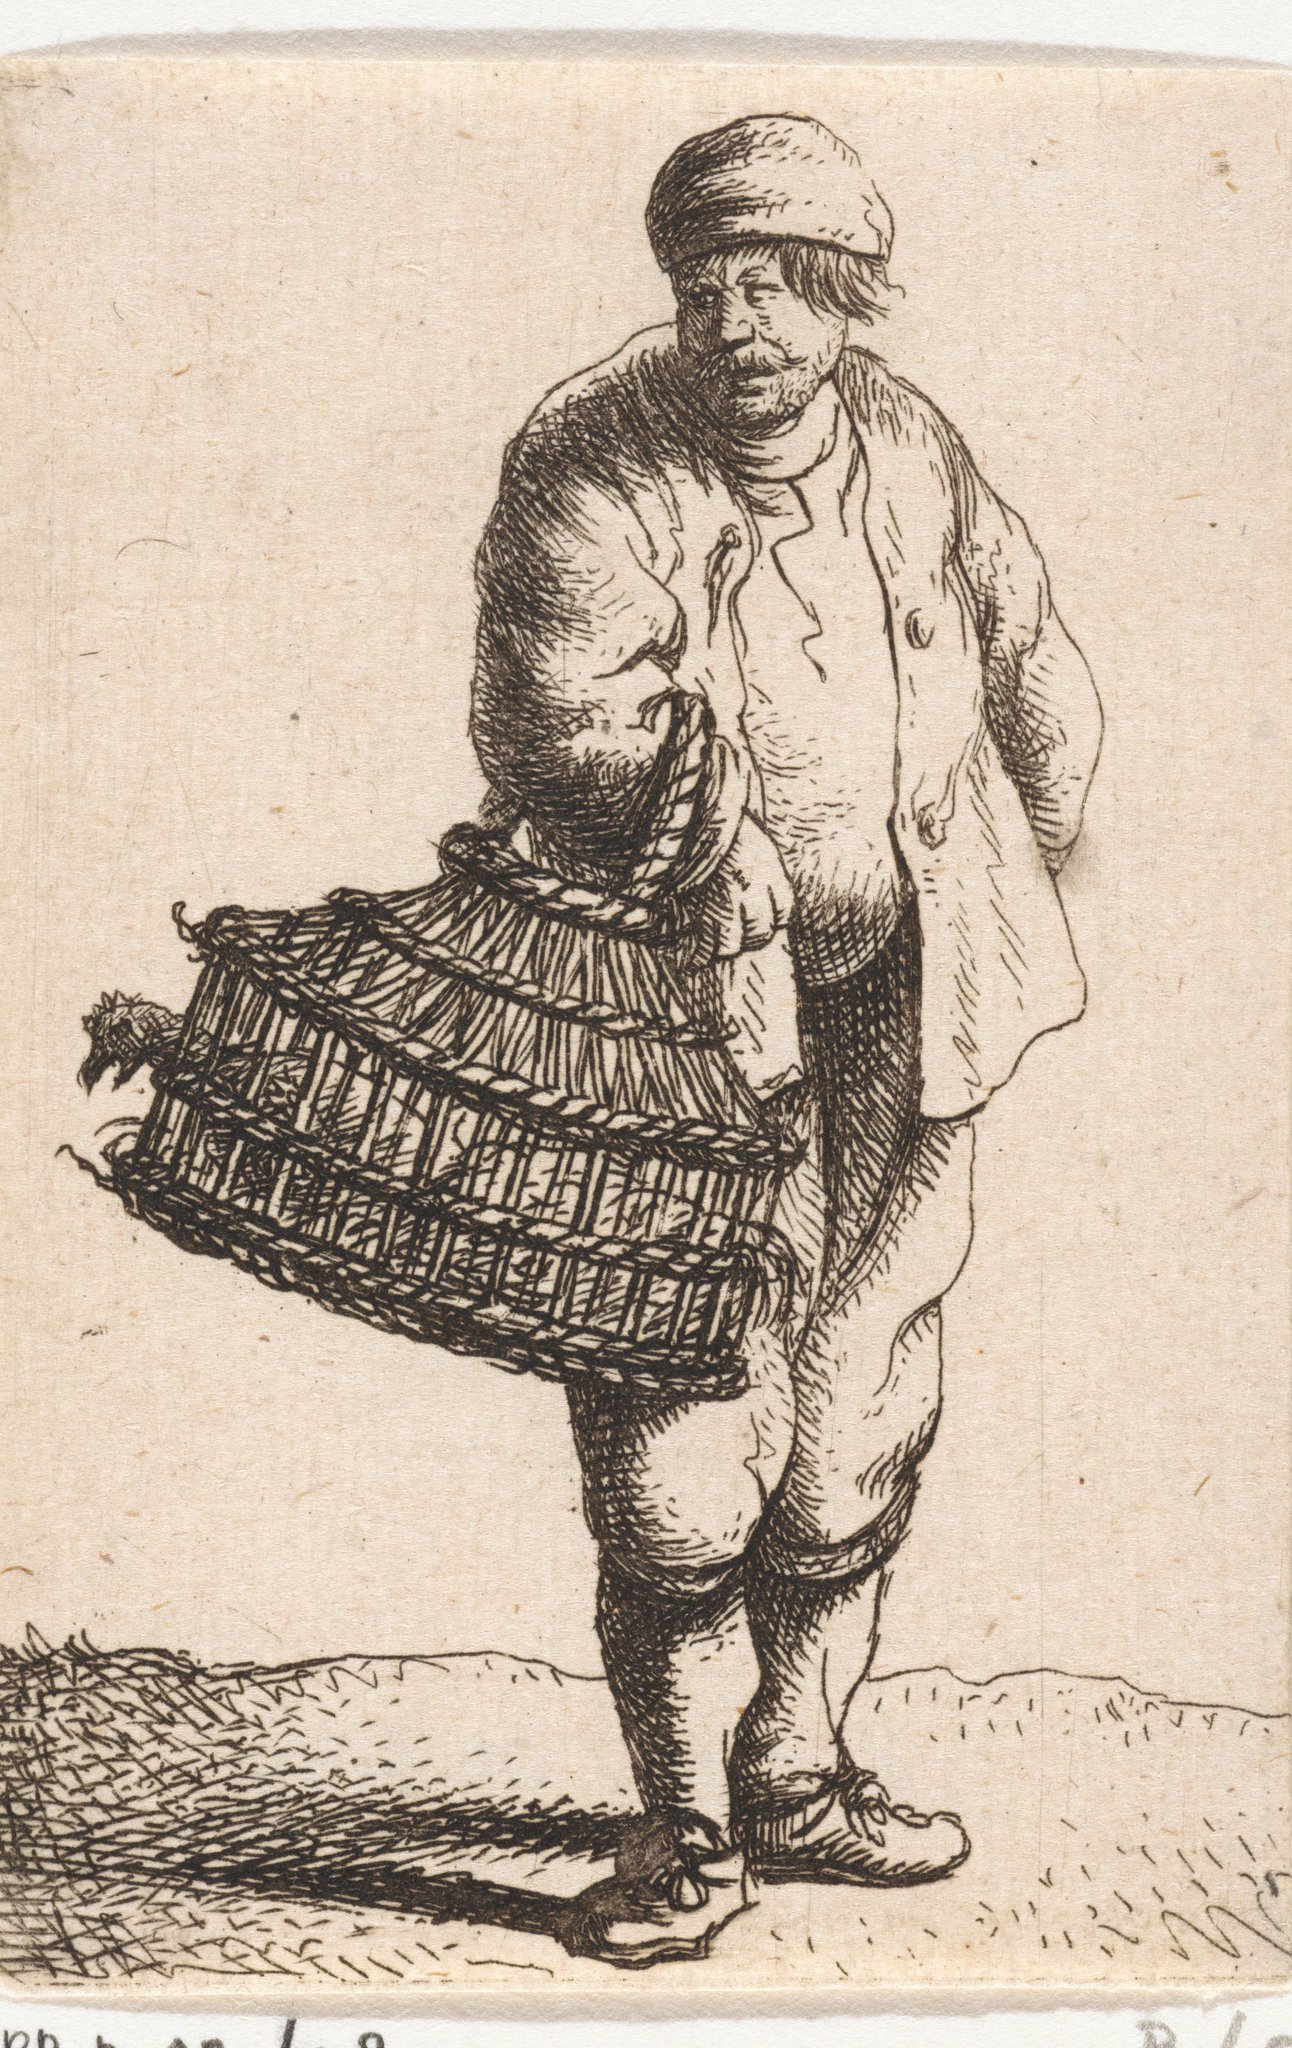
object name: print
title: Staande figuren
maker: jan gillisz. van vliet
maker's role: draughtsman, painter, print maker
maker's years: 1600-1668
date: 1635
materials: paper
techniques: etching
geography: leiden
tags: container made of plant material other than wood: basket, fowl (cock, hen, chicken, etc.)